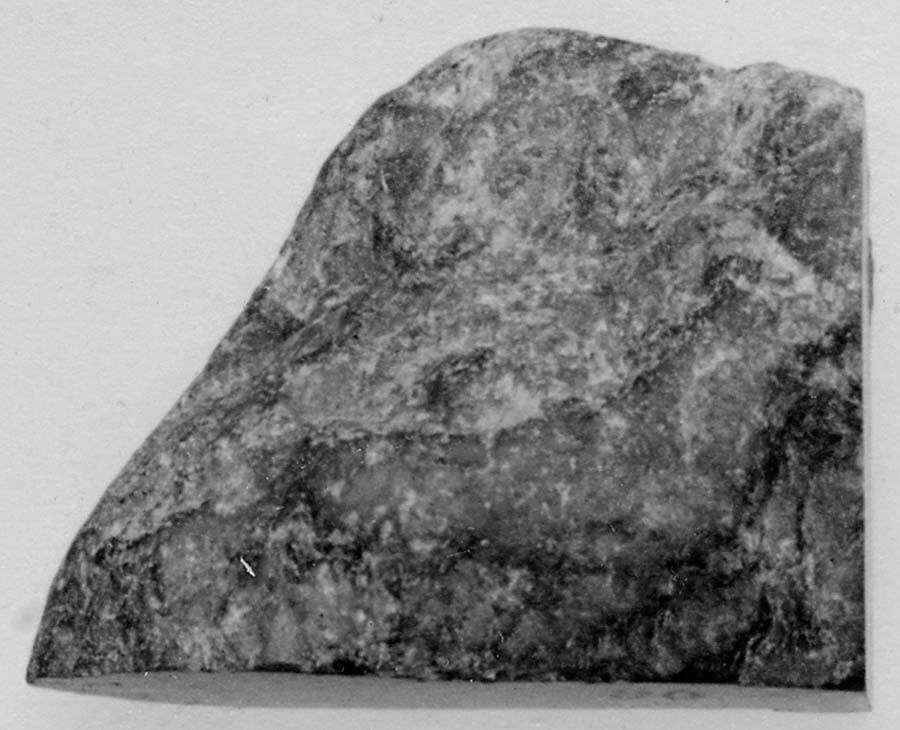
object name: fragment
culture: chinese or turkestani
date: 1902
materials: jade